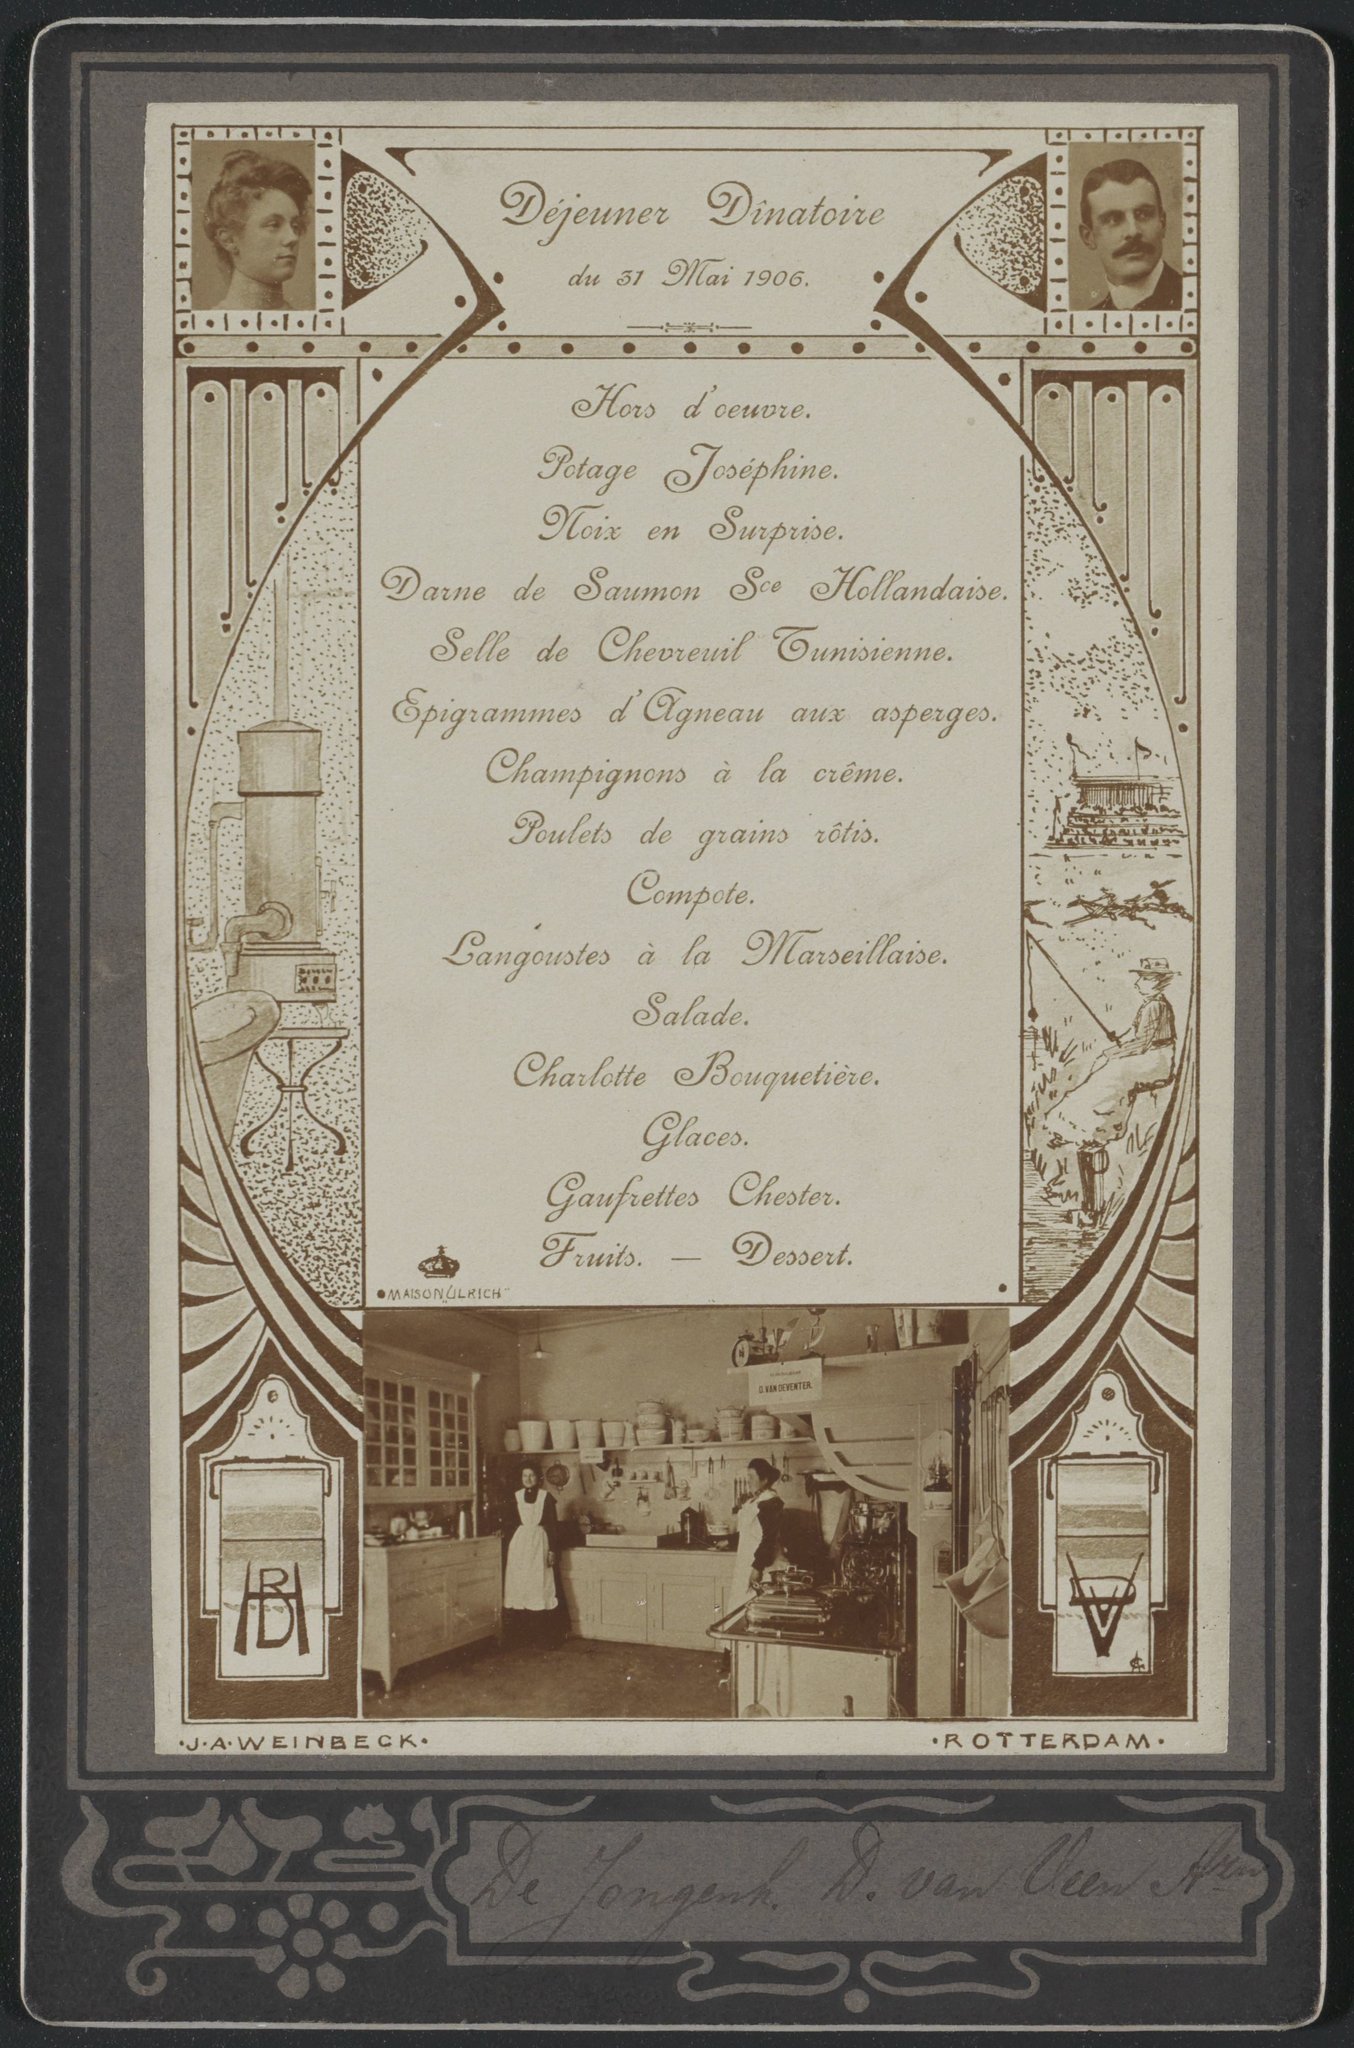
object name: cabinet photograph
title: Fotografische menukaart: 'Déjeuner Dinatoire du 31 Mai 1906' te Rotterdam (bij Maison Ulrich) ter gelegenheid het huwelijk van Dirk van Veen en Elisabeth Barendina Hooijkaas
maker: Anonymous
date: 1906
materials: cardboard, paper, photographic support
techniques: collodion silver print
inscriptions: inscription: ‘Déjeuner Dinatoire / du 31 Mai 1906. / [...] Maison Ulrich / J.A. WEINBECK / ROTTERDAM / [monogram:] BH / [monogram:] DVV’, caption: ‘De Jongenh. D. van Veen Azn’